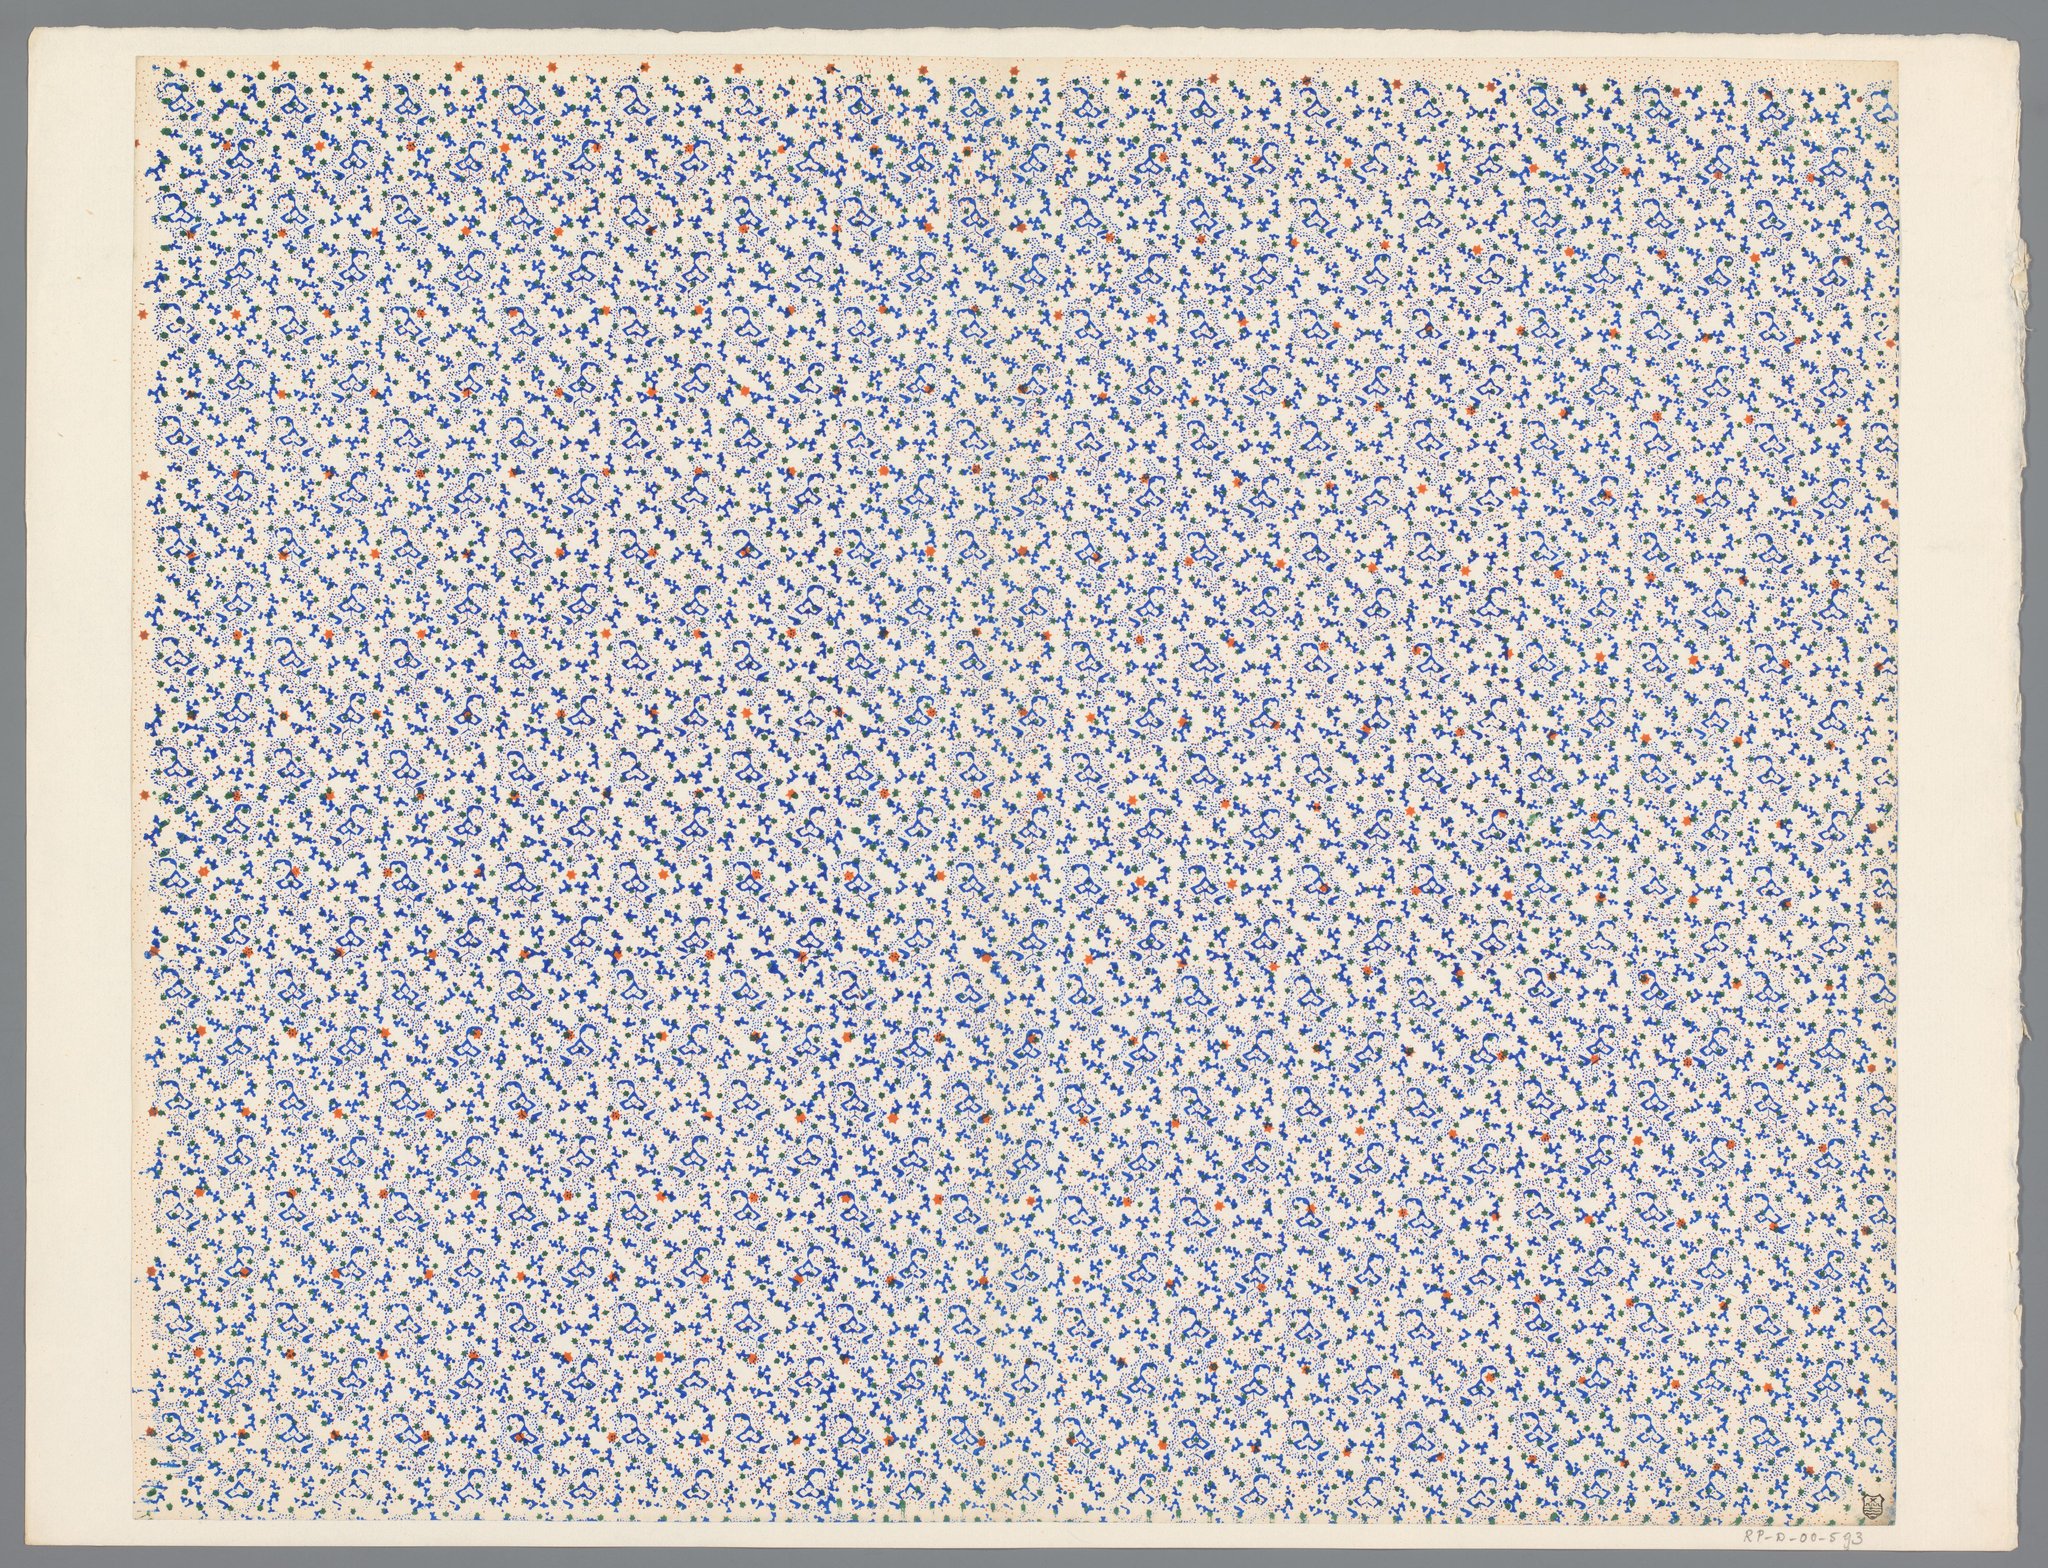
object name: printed paper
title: Blad met strooipatroon van hoekig motief en sterren met puntenfond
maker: Anonymous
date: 1800-1900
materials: paper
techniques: printing block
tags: ornament derived from plant forms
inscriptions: collector's mark: Lugt 2760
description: Blad met strooipatroon van hoekig motief in stippenwolk en grote en kleine sterren met puntenfond.